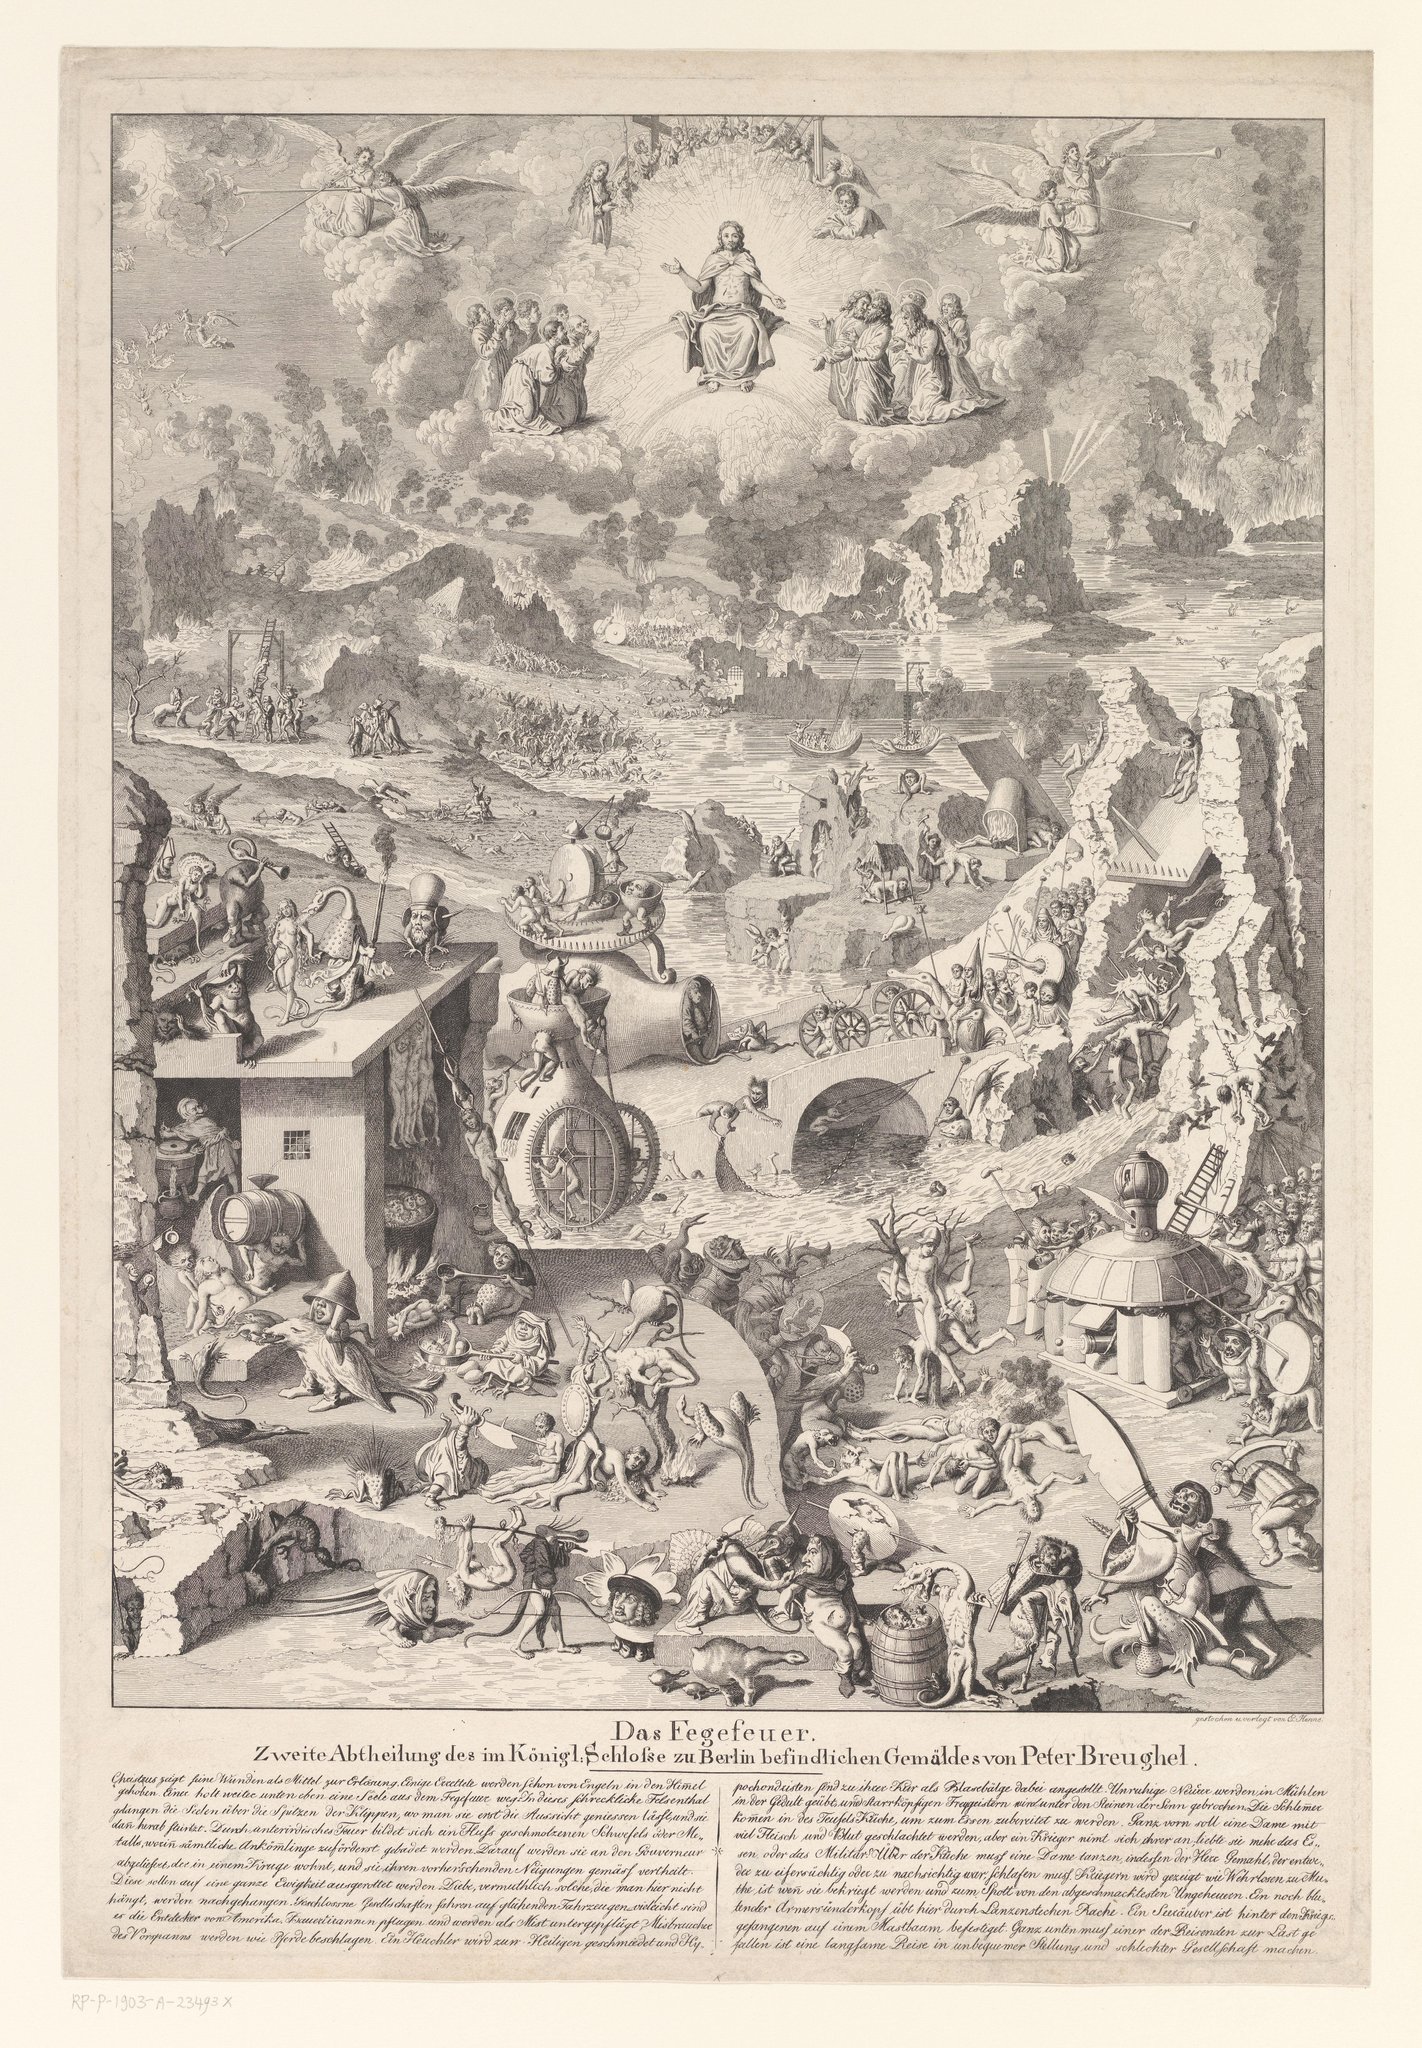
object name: print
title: Das Eegefeuer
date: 1769-1828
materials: paper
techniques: etching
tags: the damned souls, and their punishment, separate scenes ~ last judgement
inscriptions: collector's mark: Lugt 2228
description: In de tekst in de ondermarge is het ontwerp van deze prent toegeschreven aan Pieter Breughel de Oudere, maar het is gemaakt naar Jheronimus Bosch.